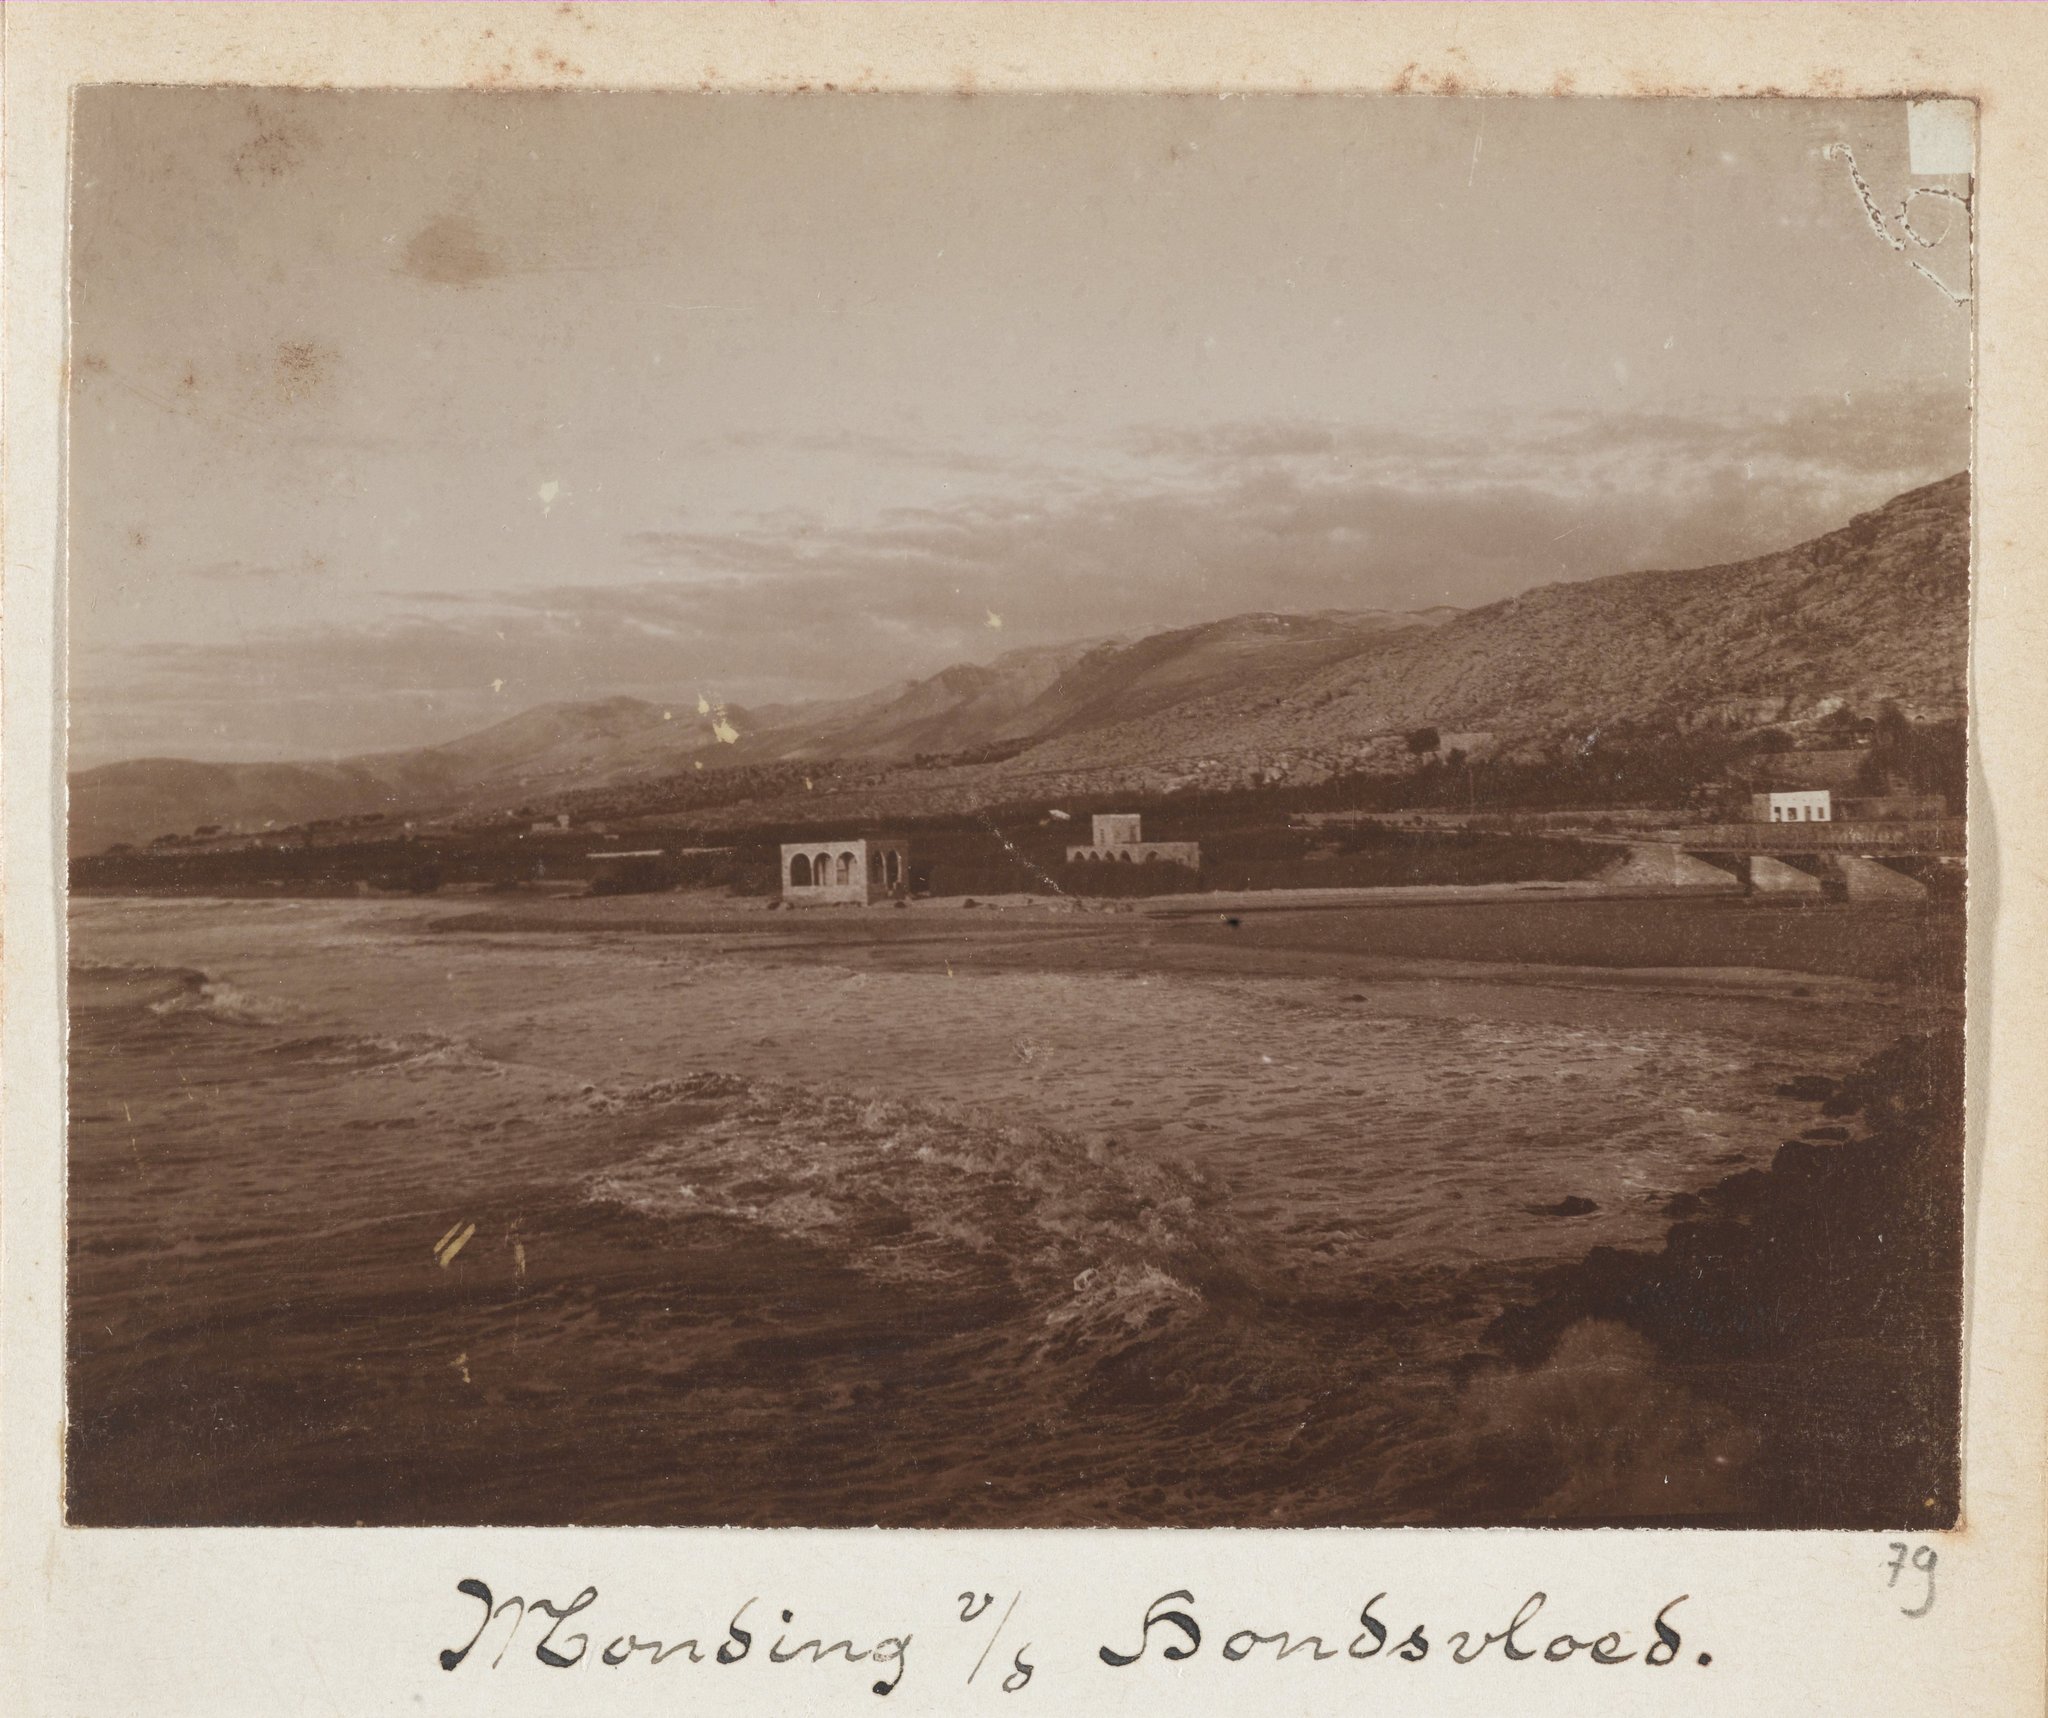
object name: page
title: Monding v/d Hondsvloed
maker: johannes lodewijk heldring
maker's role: fotograaf, predikant, schrijver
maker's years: 1852-1923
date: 1898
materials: paper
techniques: collodion silver print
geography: lebanon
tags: river